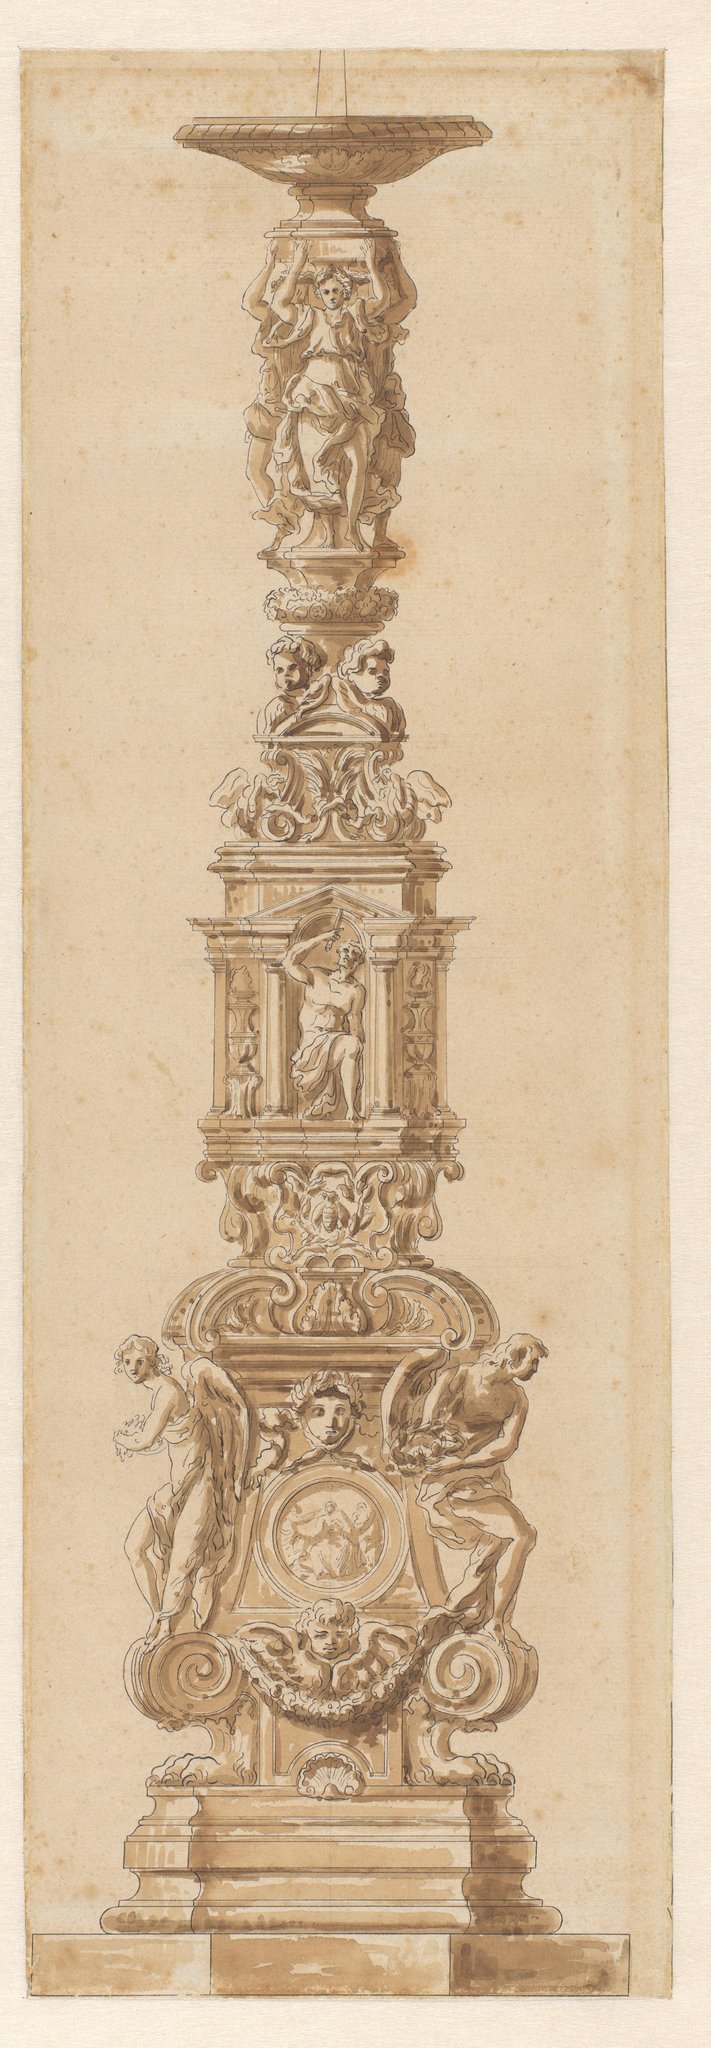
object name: drawing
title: Tekening van een zilveren kandelaar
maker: Anonymous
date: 1680-1700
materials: graphite, ink, paper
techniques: brush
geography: rome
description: Tekening van een kandelaar van zilver, omstreeks 1670 gemaakt door Carla Spagna in opdracht van kardinaal Francesco Barberini, voor het hoogaltaar van de Sint Pieter in Rome.